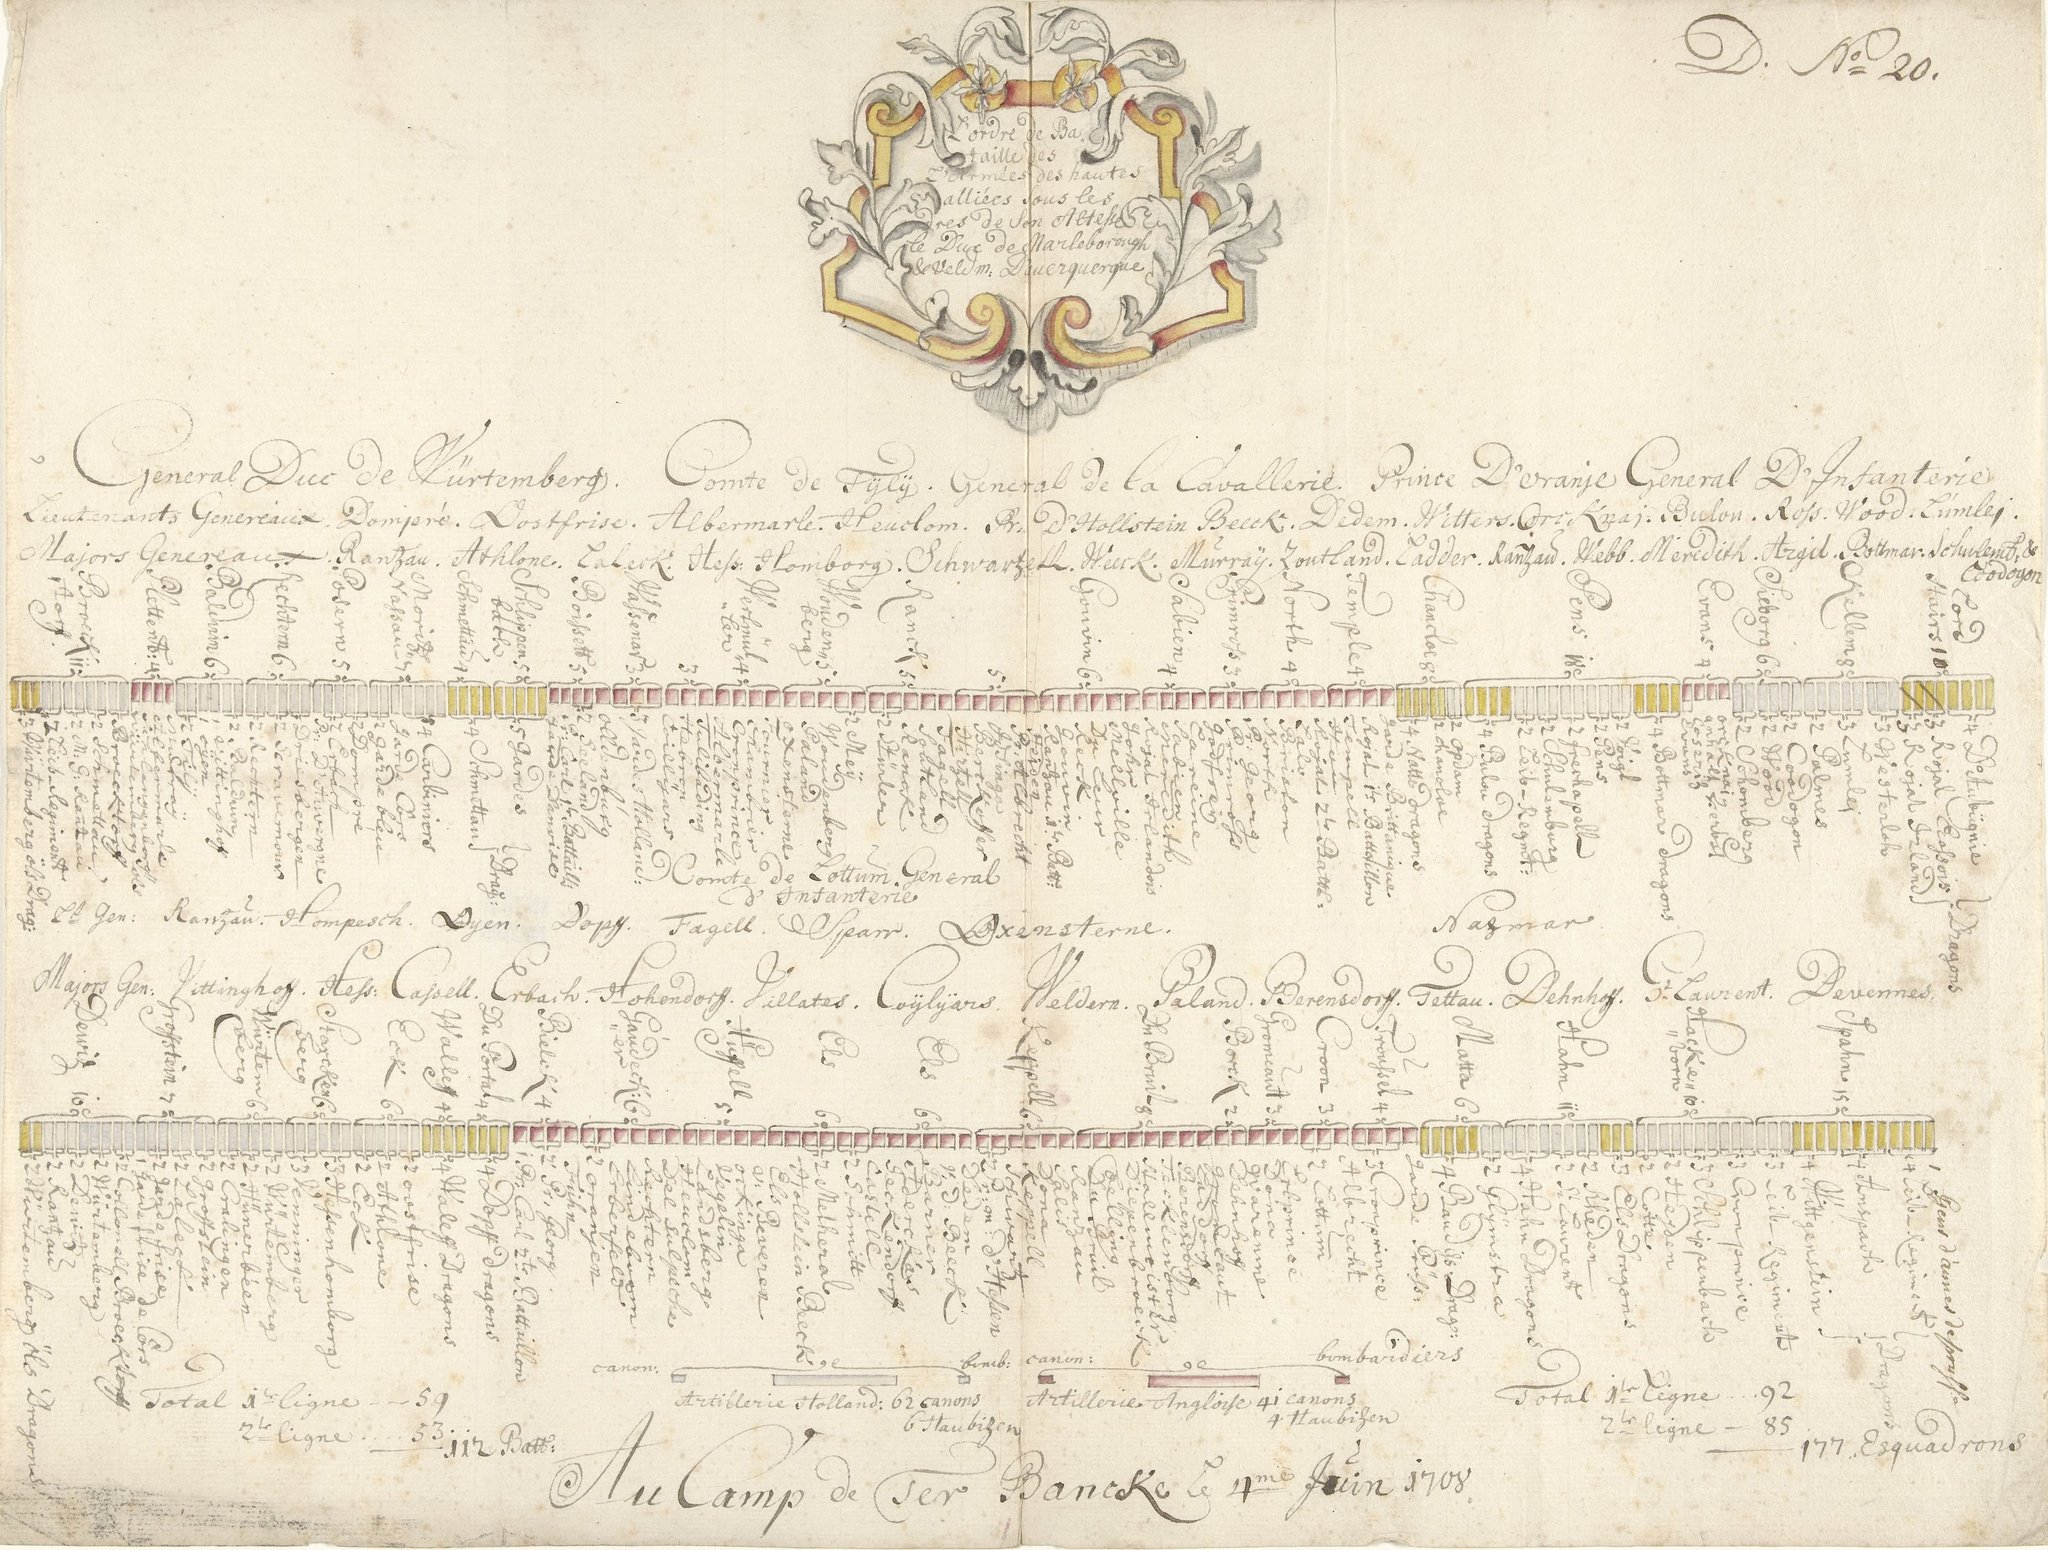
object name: map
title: L'ordre de Bataille des L'Armées des Hautes alliées sous les ordres de son Altesse le Duc de Marleborough & de le m: D'auerquerque / Au Camp de Ter Bancke le 4me Juin 1708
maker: samuel du ry de champdoré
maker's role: draughtsman, engineer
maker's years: 1651-1729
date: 1706-1708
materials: paper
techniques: writing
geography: netherlands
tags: john churchill (1e hertog van marlborough), battle arrays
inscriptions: collector's mark: Lugt 2166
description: Slagorde van de geallieerde troepen onder de hertog van Marlborough en de Heer van Ouwerkerk in het legerkamp bij Terbank, juni 1708. Bovenaan een cartouche met de titel. Met alle namen met handschrift. Blad ligt los in het album. Onderdeel van een verzameling getekende plannen van versterkte plaatsen in Nederland en omringende landen ten tijde van de Spaanse Successieoorlog (deel D).